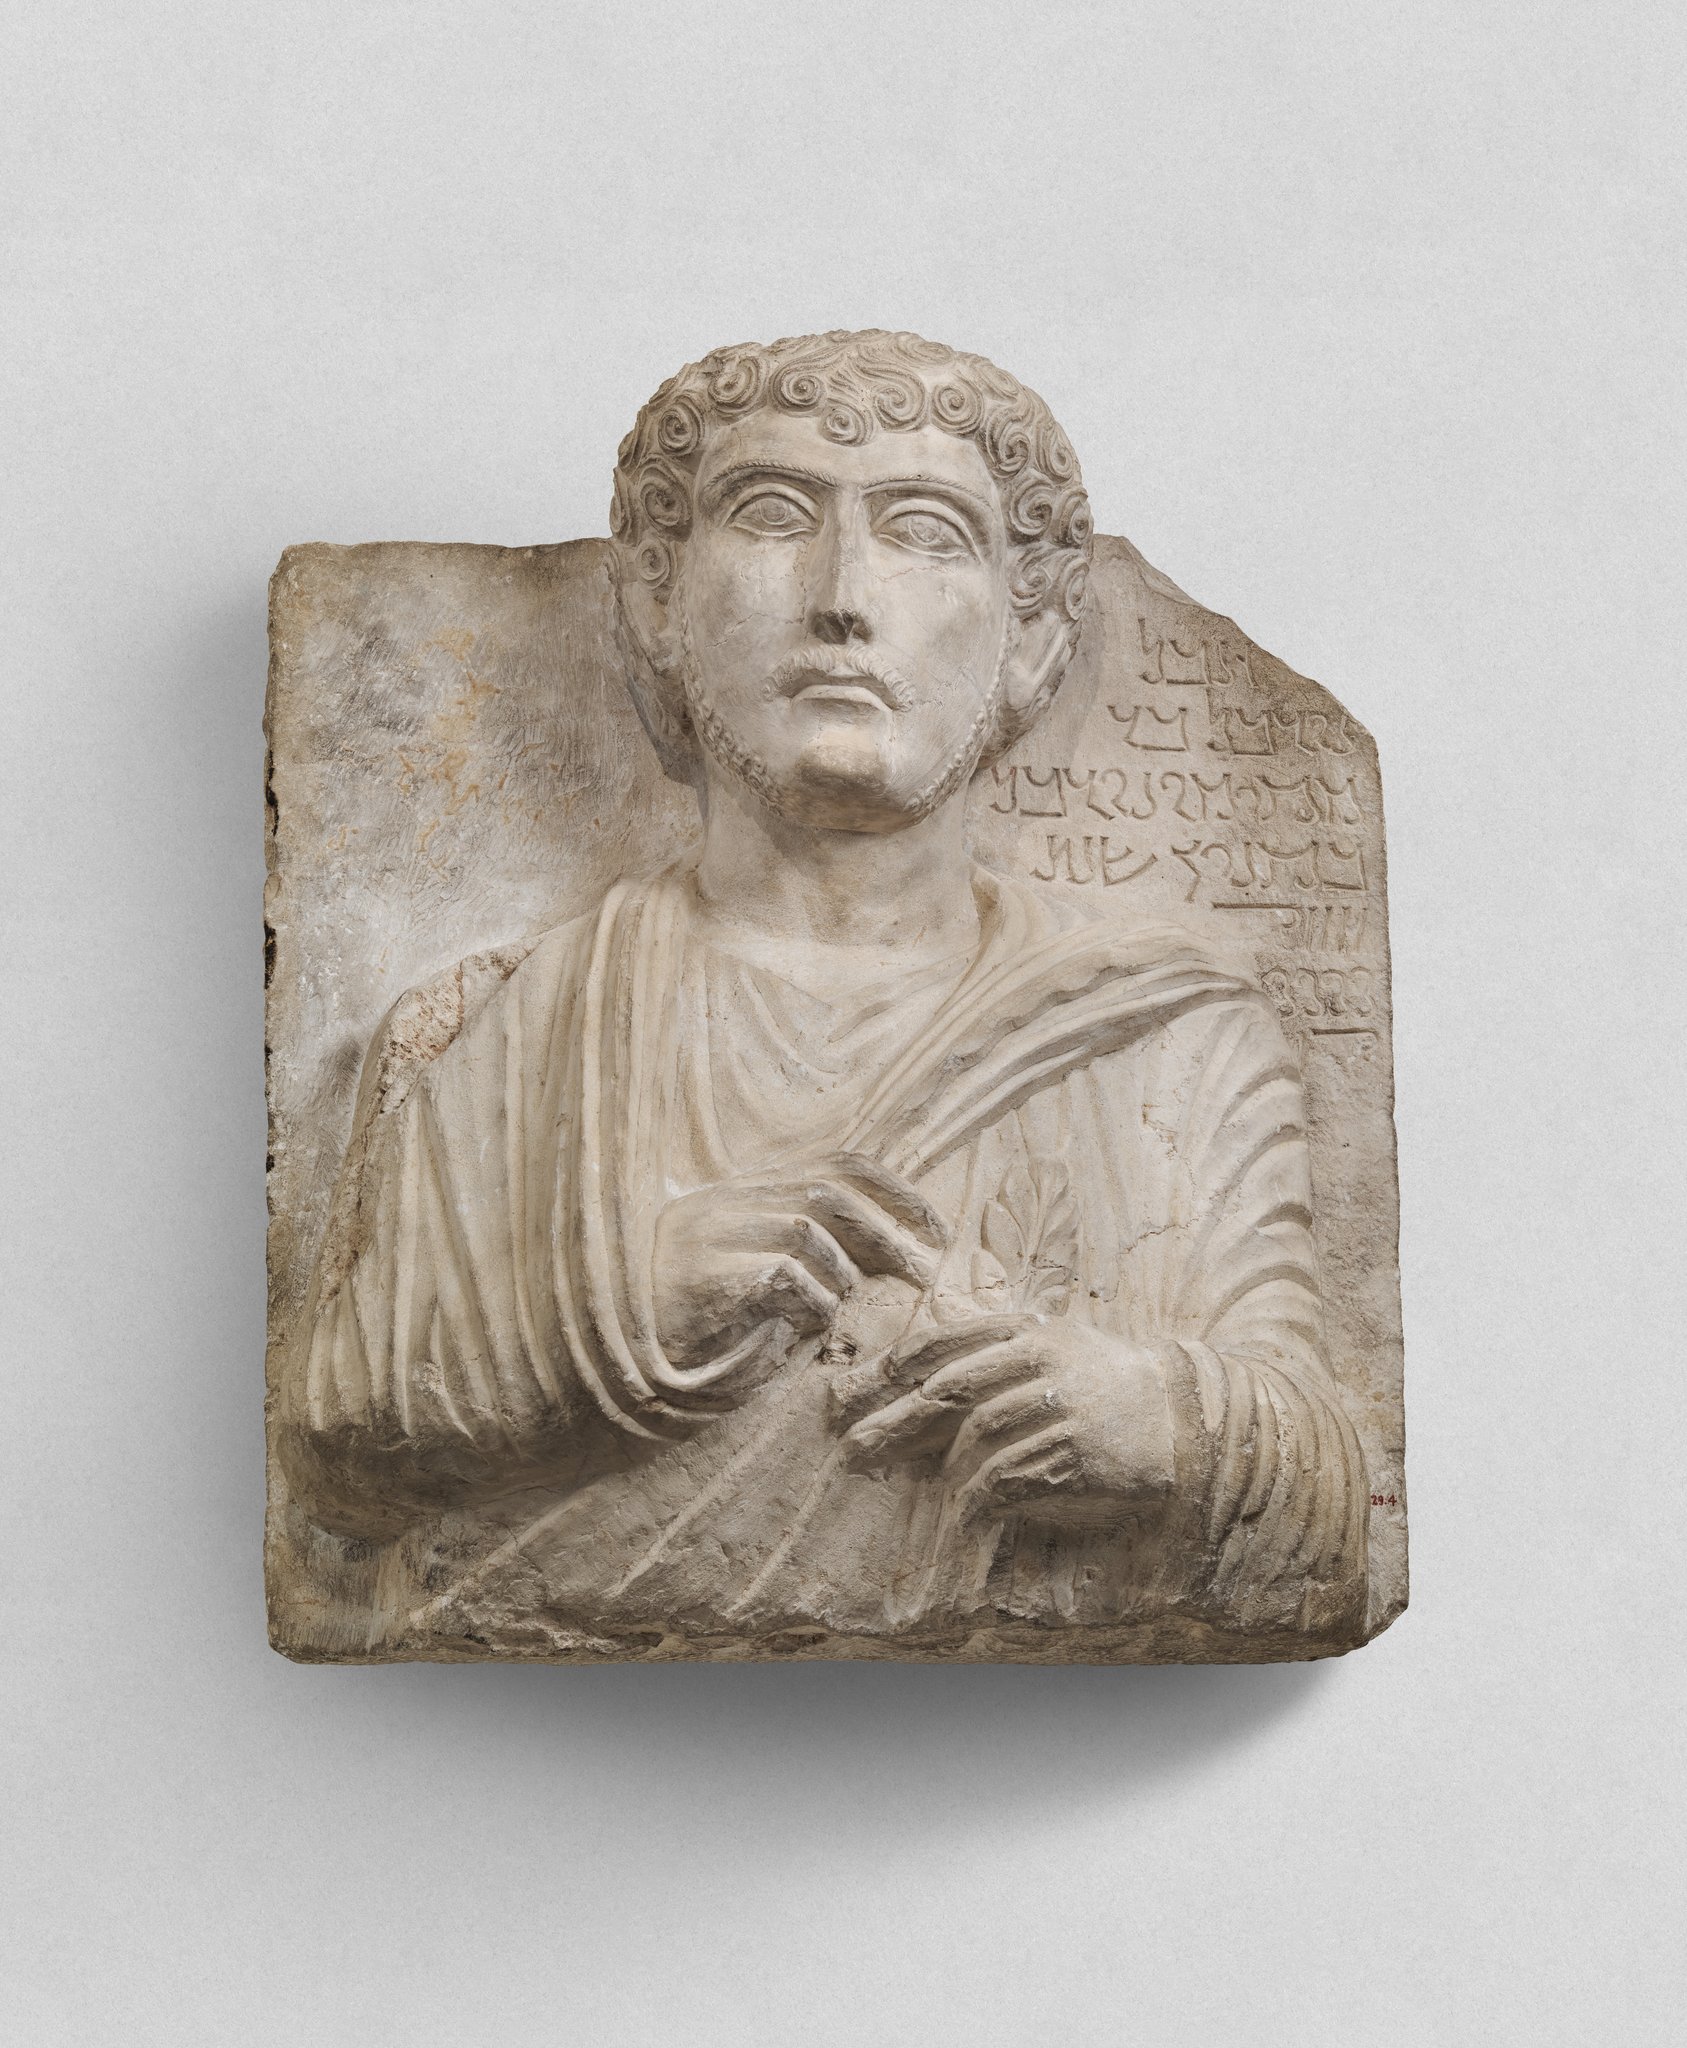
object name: funerary relief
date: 181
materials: limestone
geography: syria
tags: men